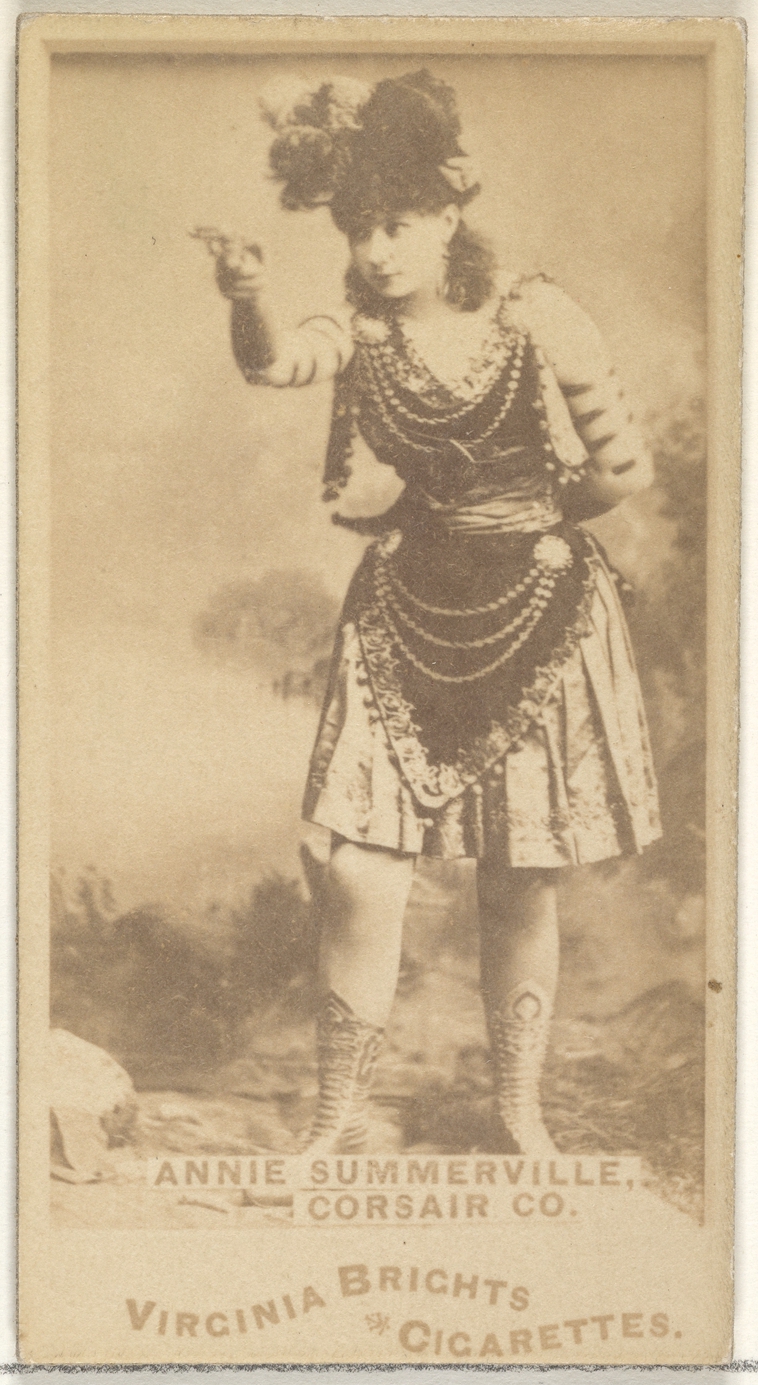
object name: photograph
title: Annie Summerville, Corsair Co., from the Actors and Actresses series (N45, Type 1) for Virginia Brights Cigarettes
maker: allen & ginter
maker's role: publisher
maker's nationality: american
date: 1888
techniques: albumen silver print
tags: portraits,women,actresses